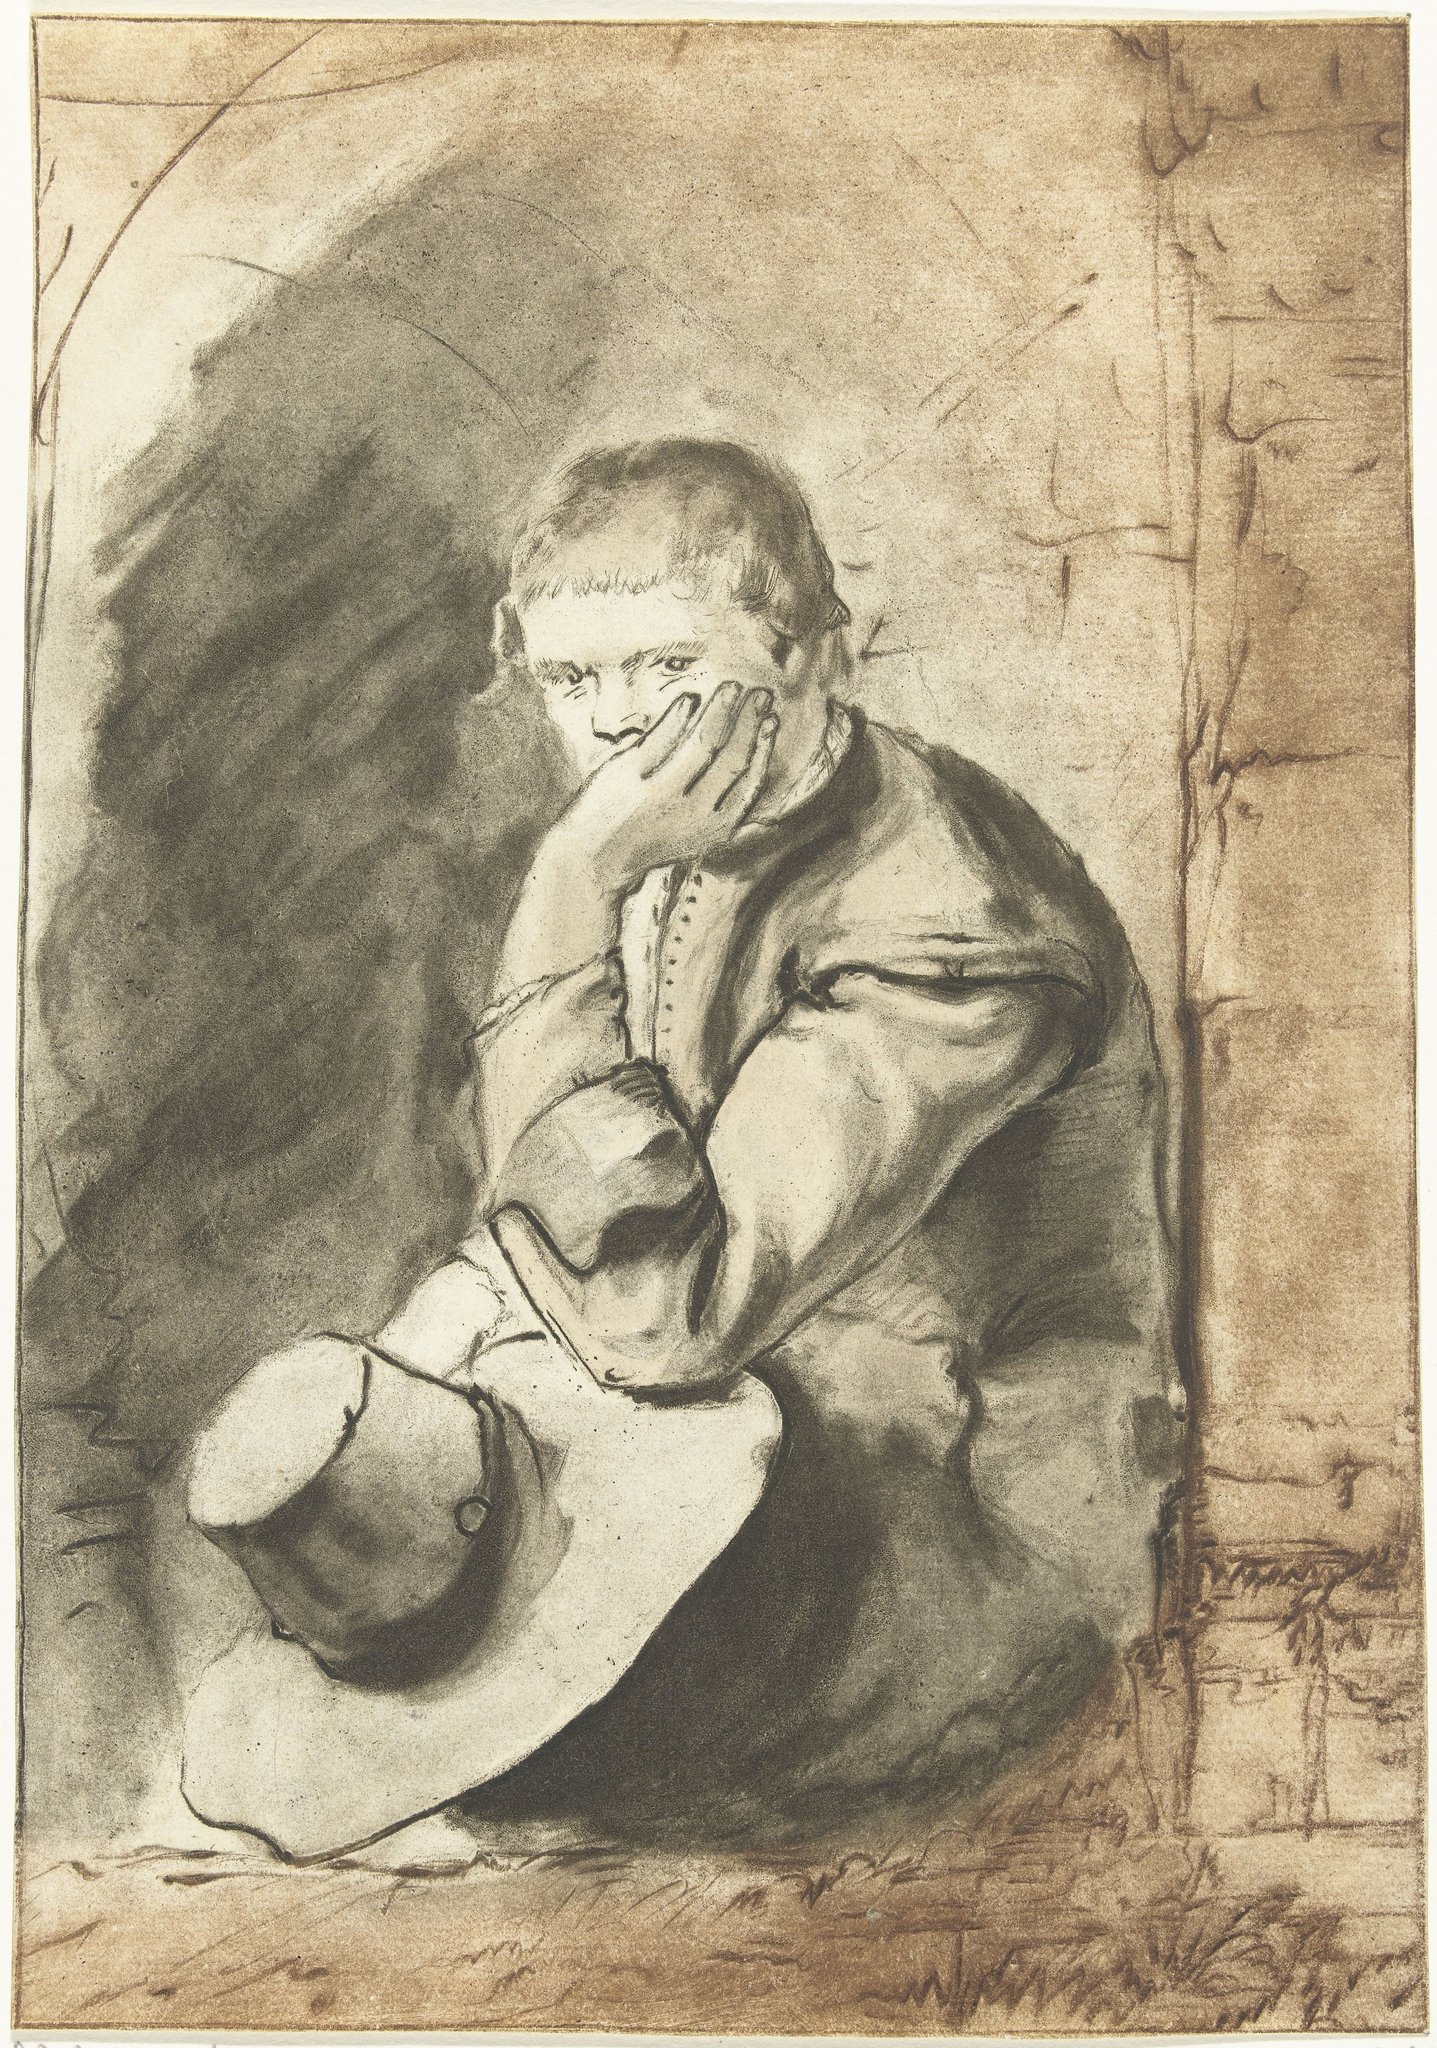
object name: print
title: Zittende man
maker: jurriaan cootwijck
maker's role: print maker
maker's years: 1714-1798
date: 1724-1798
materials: paper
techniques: aquatint, hand coloring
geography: amsterdam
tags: sitting figure (+ adult male (human being))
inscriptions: inscription: ‘april E tot 1835 vo. 42S’, collector's mark: Lugt 2228, collector's mark: Lugt 2760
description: Een man zit in een nis. Met zijn ene hand ondersteunt hij zijn hoofd. In zijn andere hand houdt hij zijn hoed vast.